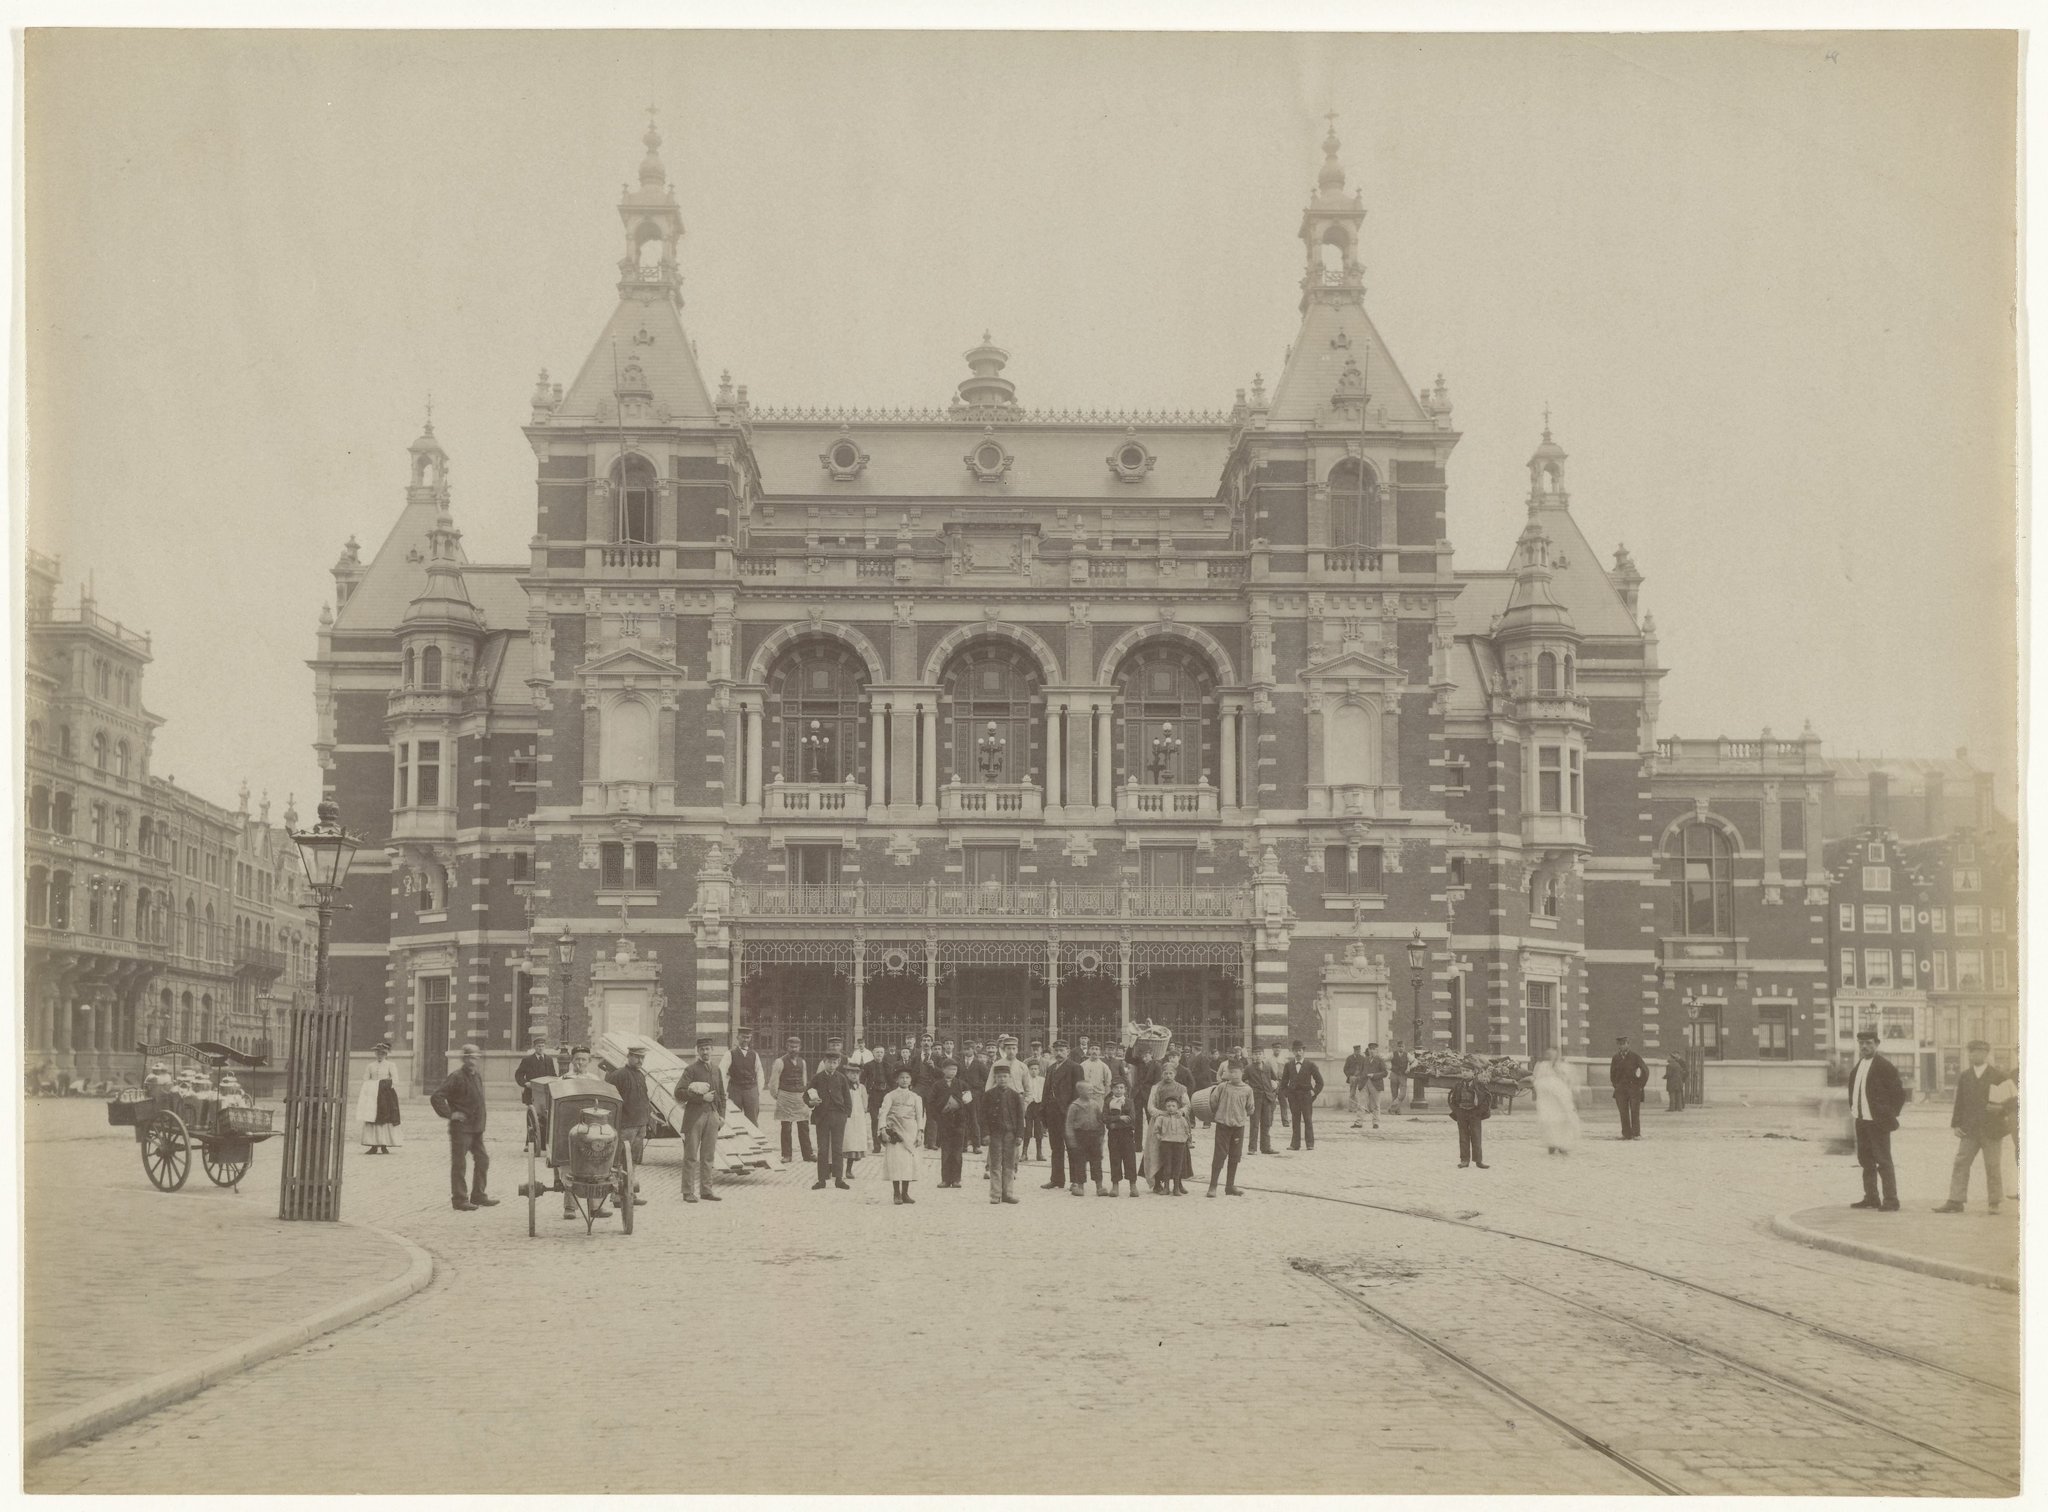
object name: photograph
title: Mensen voor de stadsschouwburg aan het Leidseplein in Amsterdam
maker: Anonymous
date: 1895-1900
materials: paper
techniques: albumen print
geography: amsterdam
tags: theatre (building), square, place, circus, etc. (+ city(-scape) with figures, staffage)